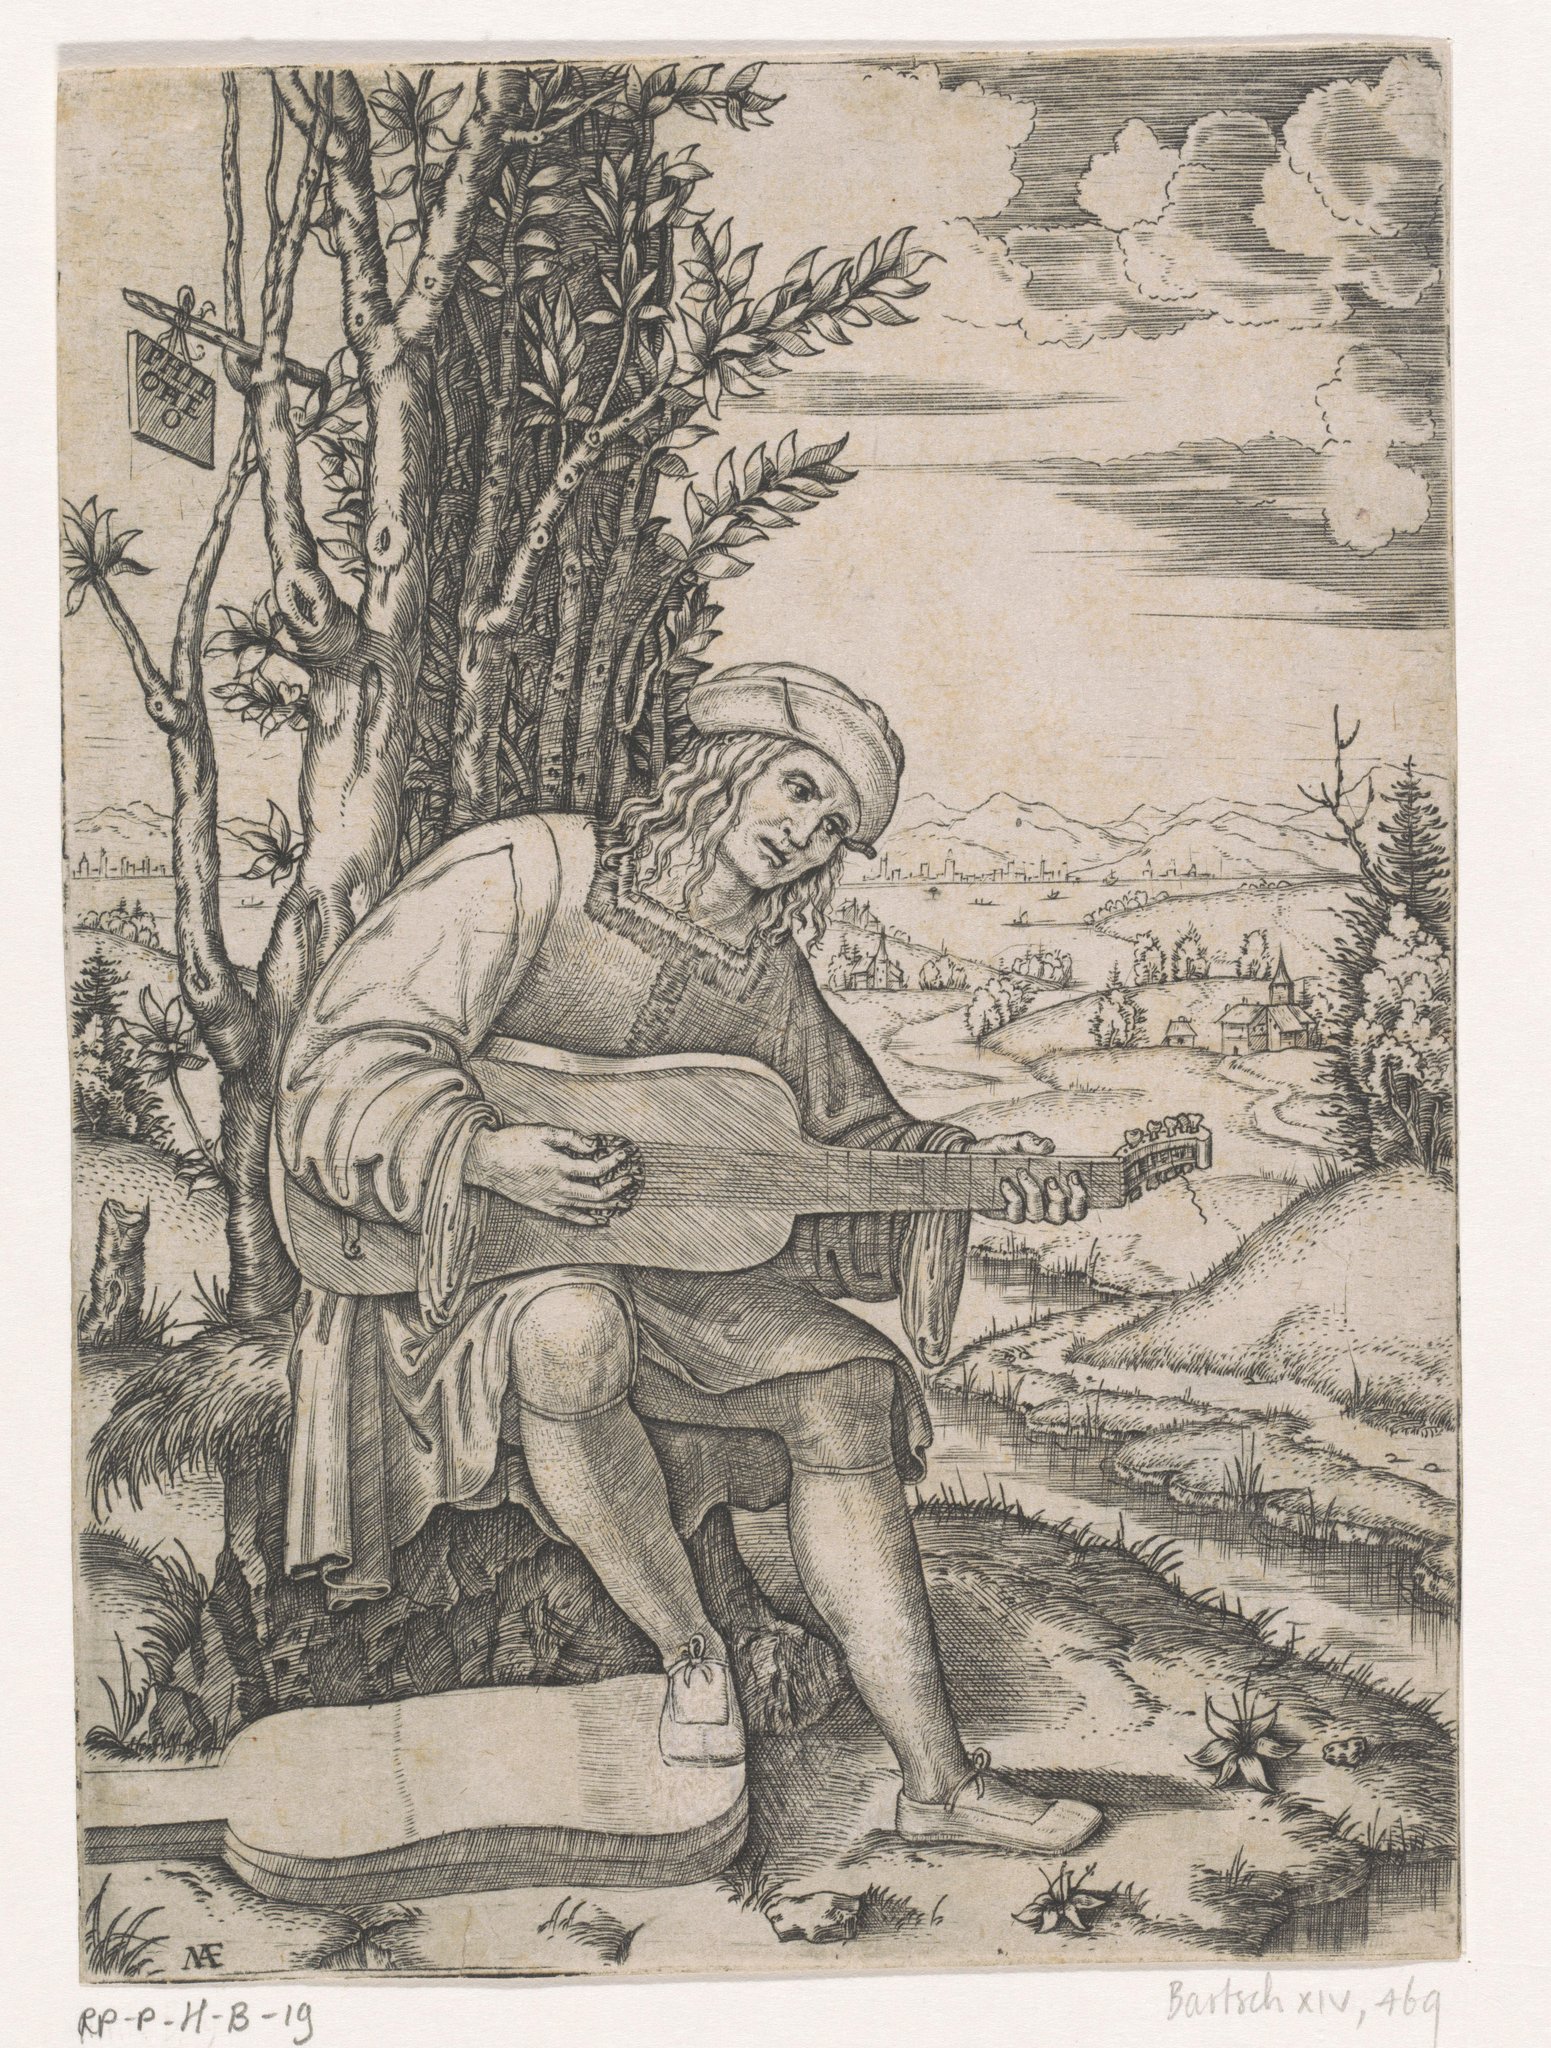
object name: print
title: Portret van Jean-Philotée Achillini spelend op een vihuela de mano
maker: marcantonio raimondi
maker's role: print maker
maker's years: 1470-1534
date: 1510-1527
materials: paper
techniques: engraving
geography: italy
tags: making music; musician with instrument, cithern, mandolin, guitar, balalaika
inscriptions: collector's mark: Lugt 10, collector's mark: Lugt 11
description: Man zittend in landschap, mogelijk Jean-Philotée Achillini (1466-1538), speelt op een vihuela de mano (een acht-vormig snaarinstrument). Op een tekstbordje dat hangt in de boom staat een naam: PHIL/ONE/O.